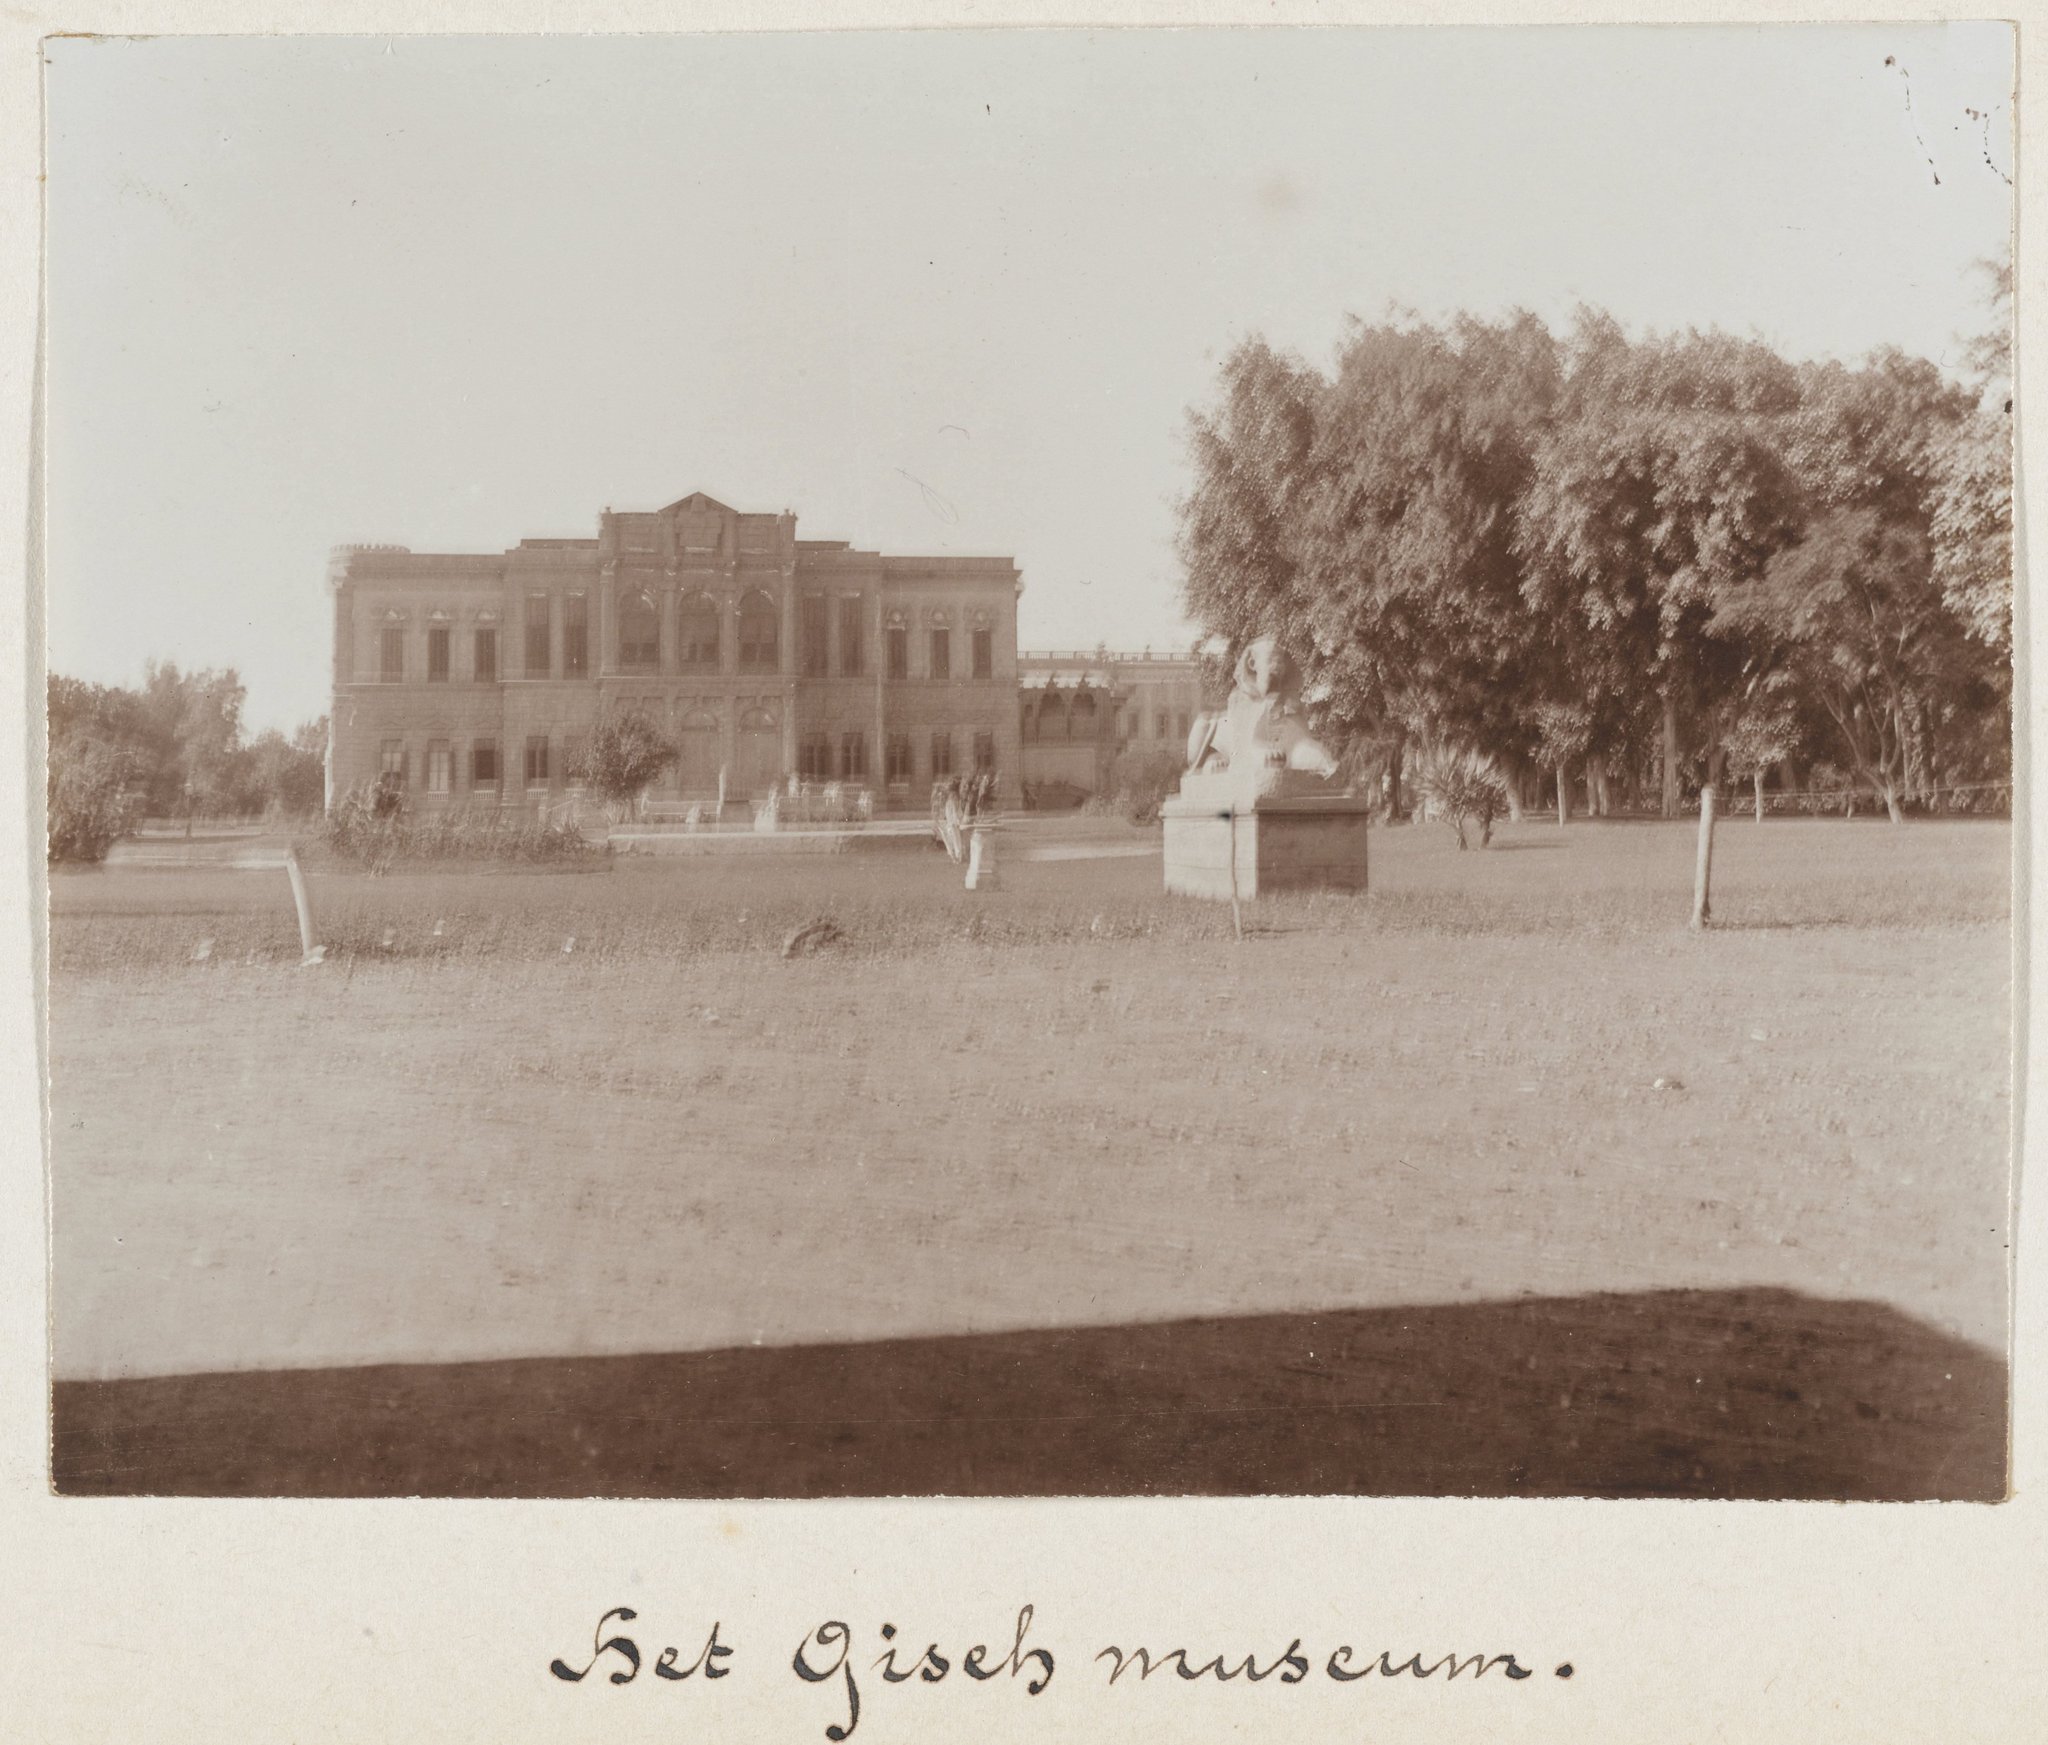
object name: photograph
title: Het Giseh museum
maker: johannes lodewijk heldring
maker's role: fotograaf, predikant, schrijver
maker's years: 1852-1923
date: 1898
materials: paper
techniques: collodion silver print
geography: gizeh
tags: permanent exhibition, museum